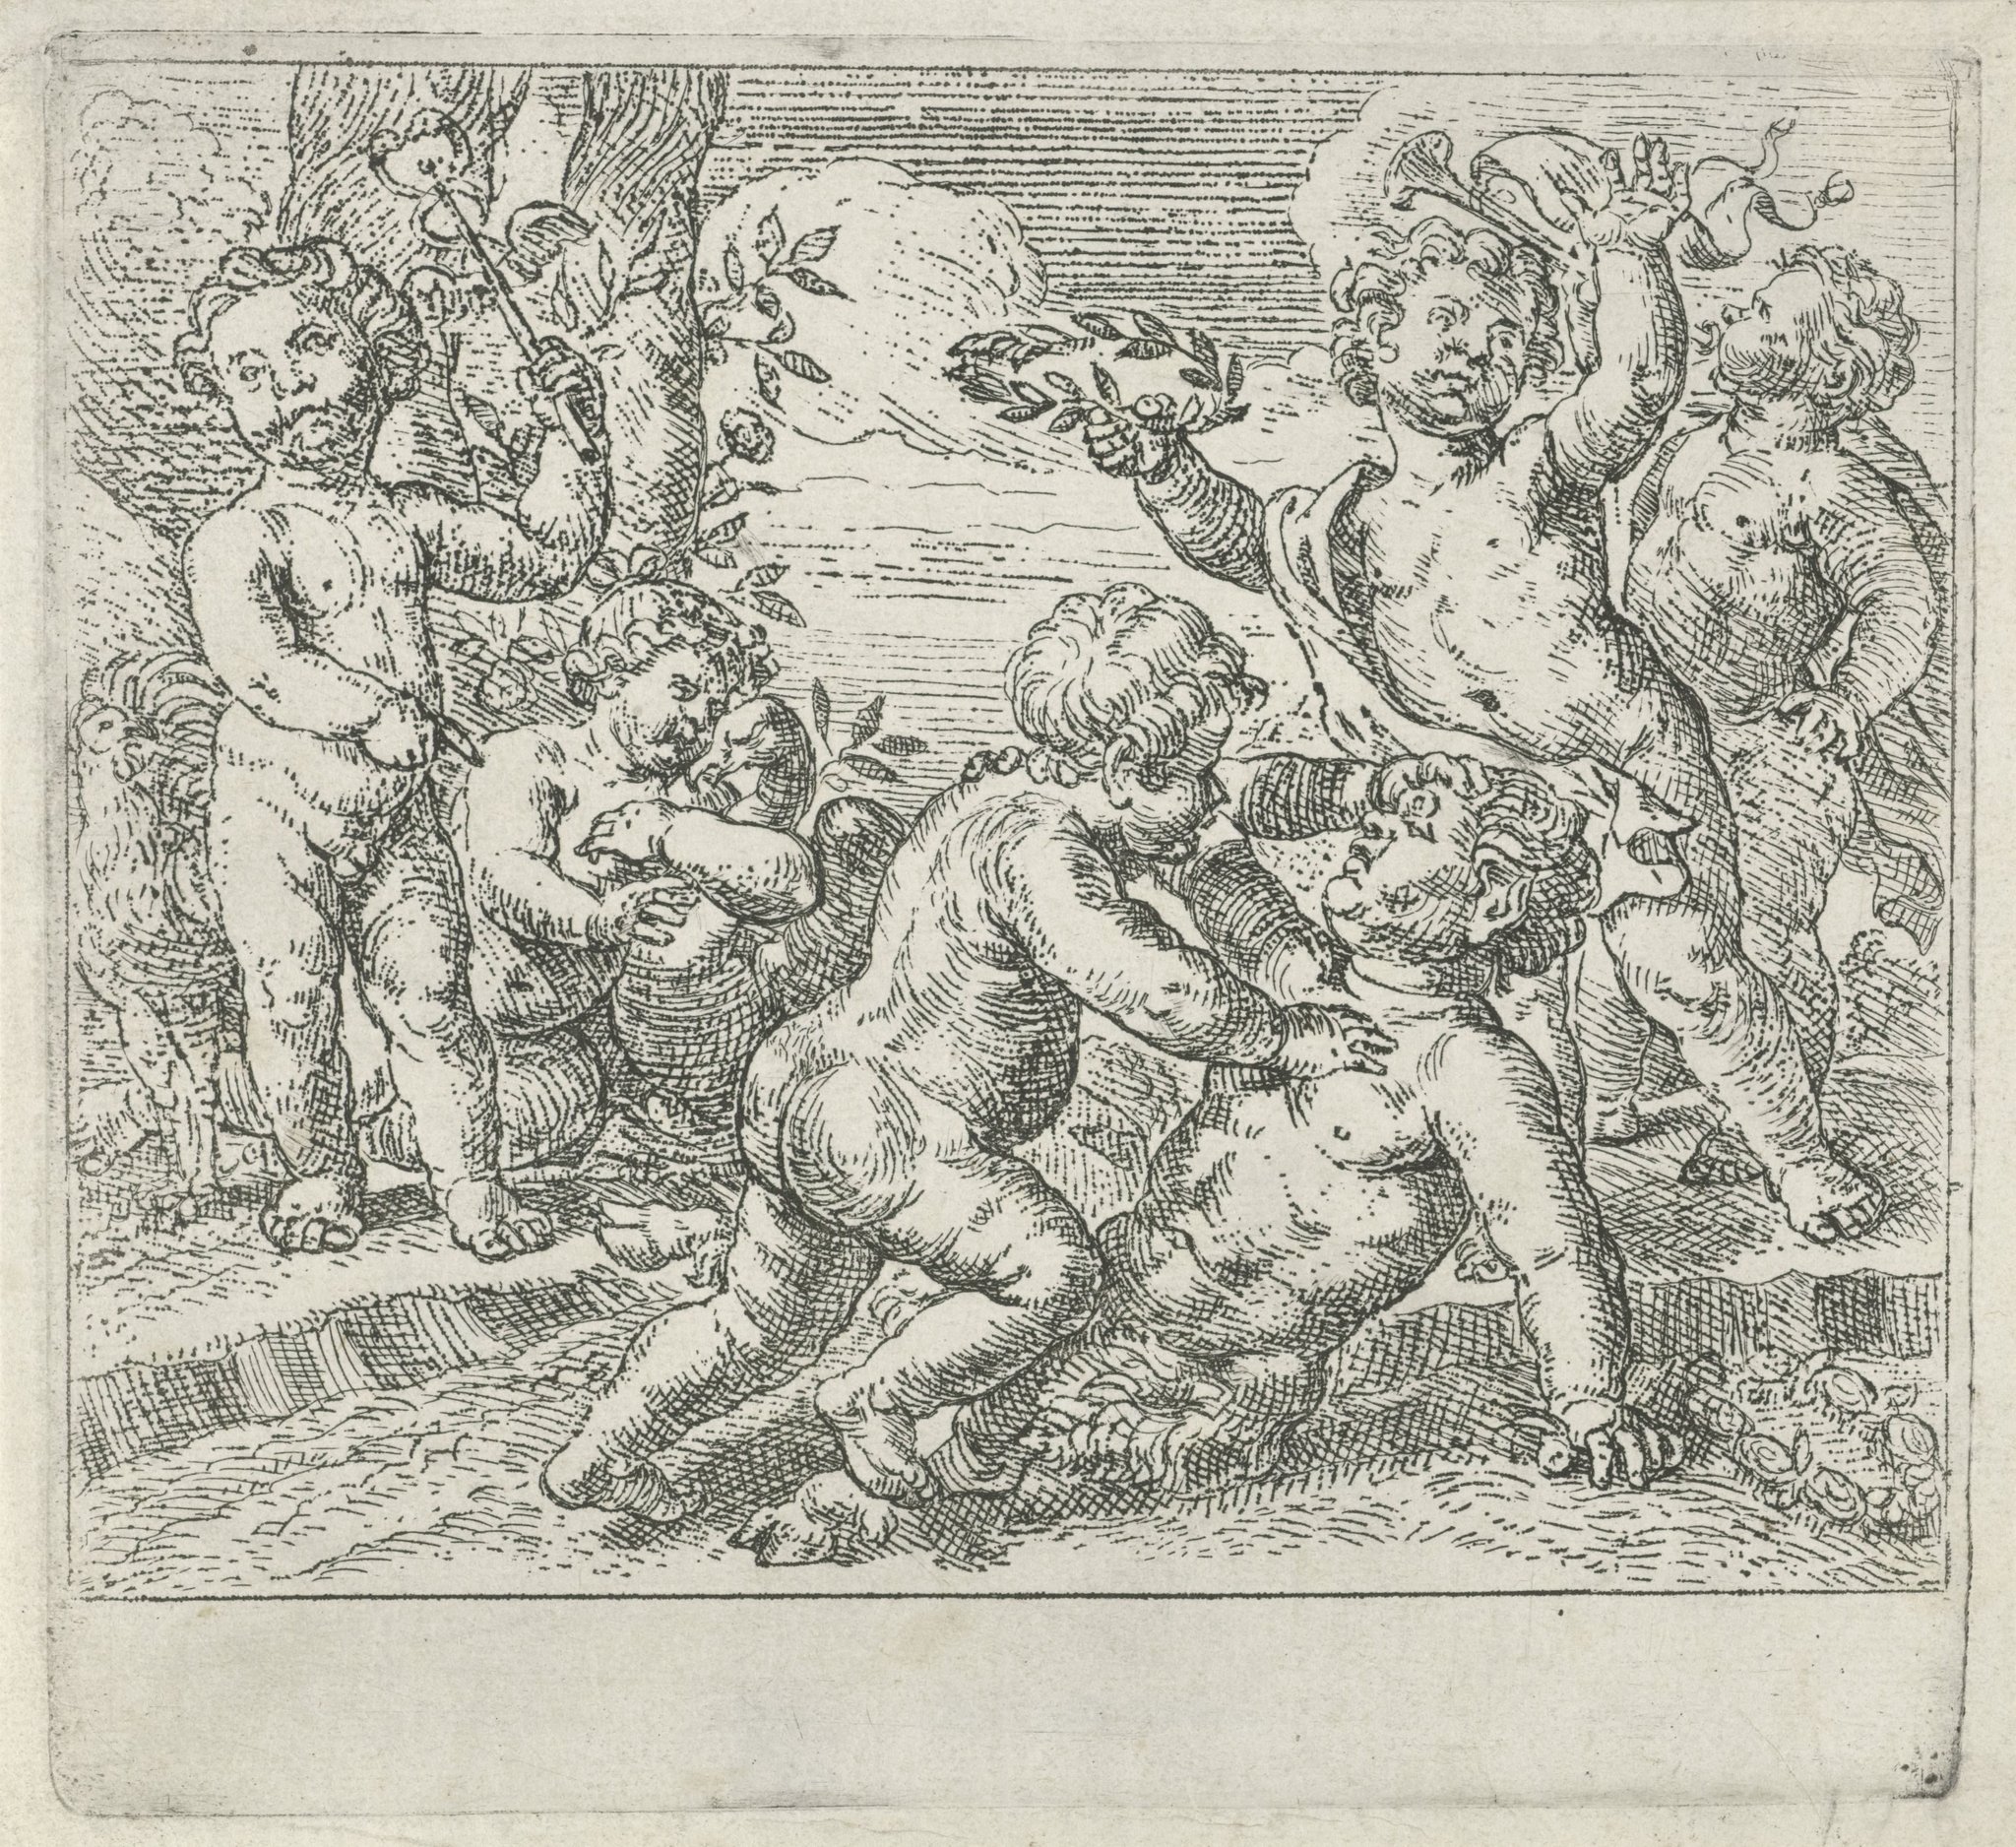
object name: print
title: Vechtende putti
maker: peter van lint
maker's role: draughtsman, painter, print maker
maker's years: 1609-1690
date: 1619-1690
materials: paper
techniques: etching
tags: figure representing a virtue vs. a vice, cupids: 'amores', 'amoretti', 'putti'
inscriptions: collector's mark: Lugt 2228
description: Twee vechtende putti op de voorgrond symboliseren de strijd tussen de deugd en de ondeugd. Rechts staat een putto met lauwerkrans klaar voor de overwinnaar, links kijkt een putto met caduceus toe. Op de achtergrond blaast een putto de bazuin, een andere putto houdt een vogel in zijn armen.